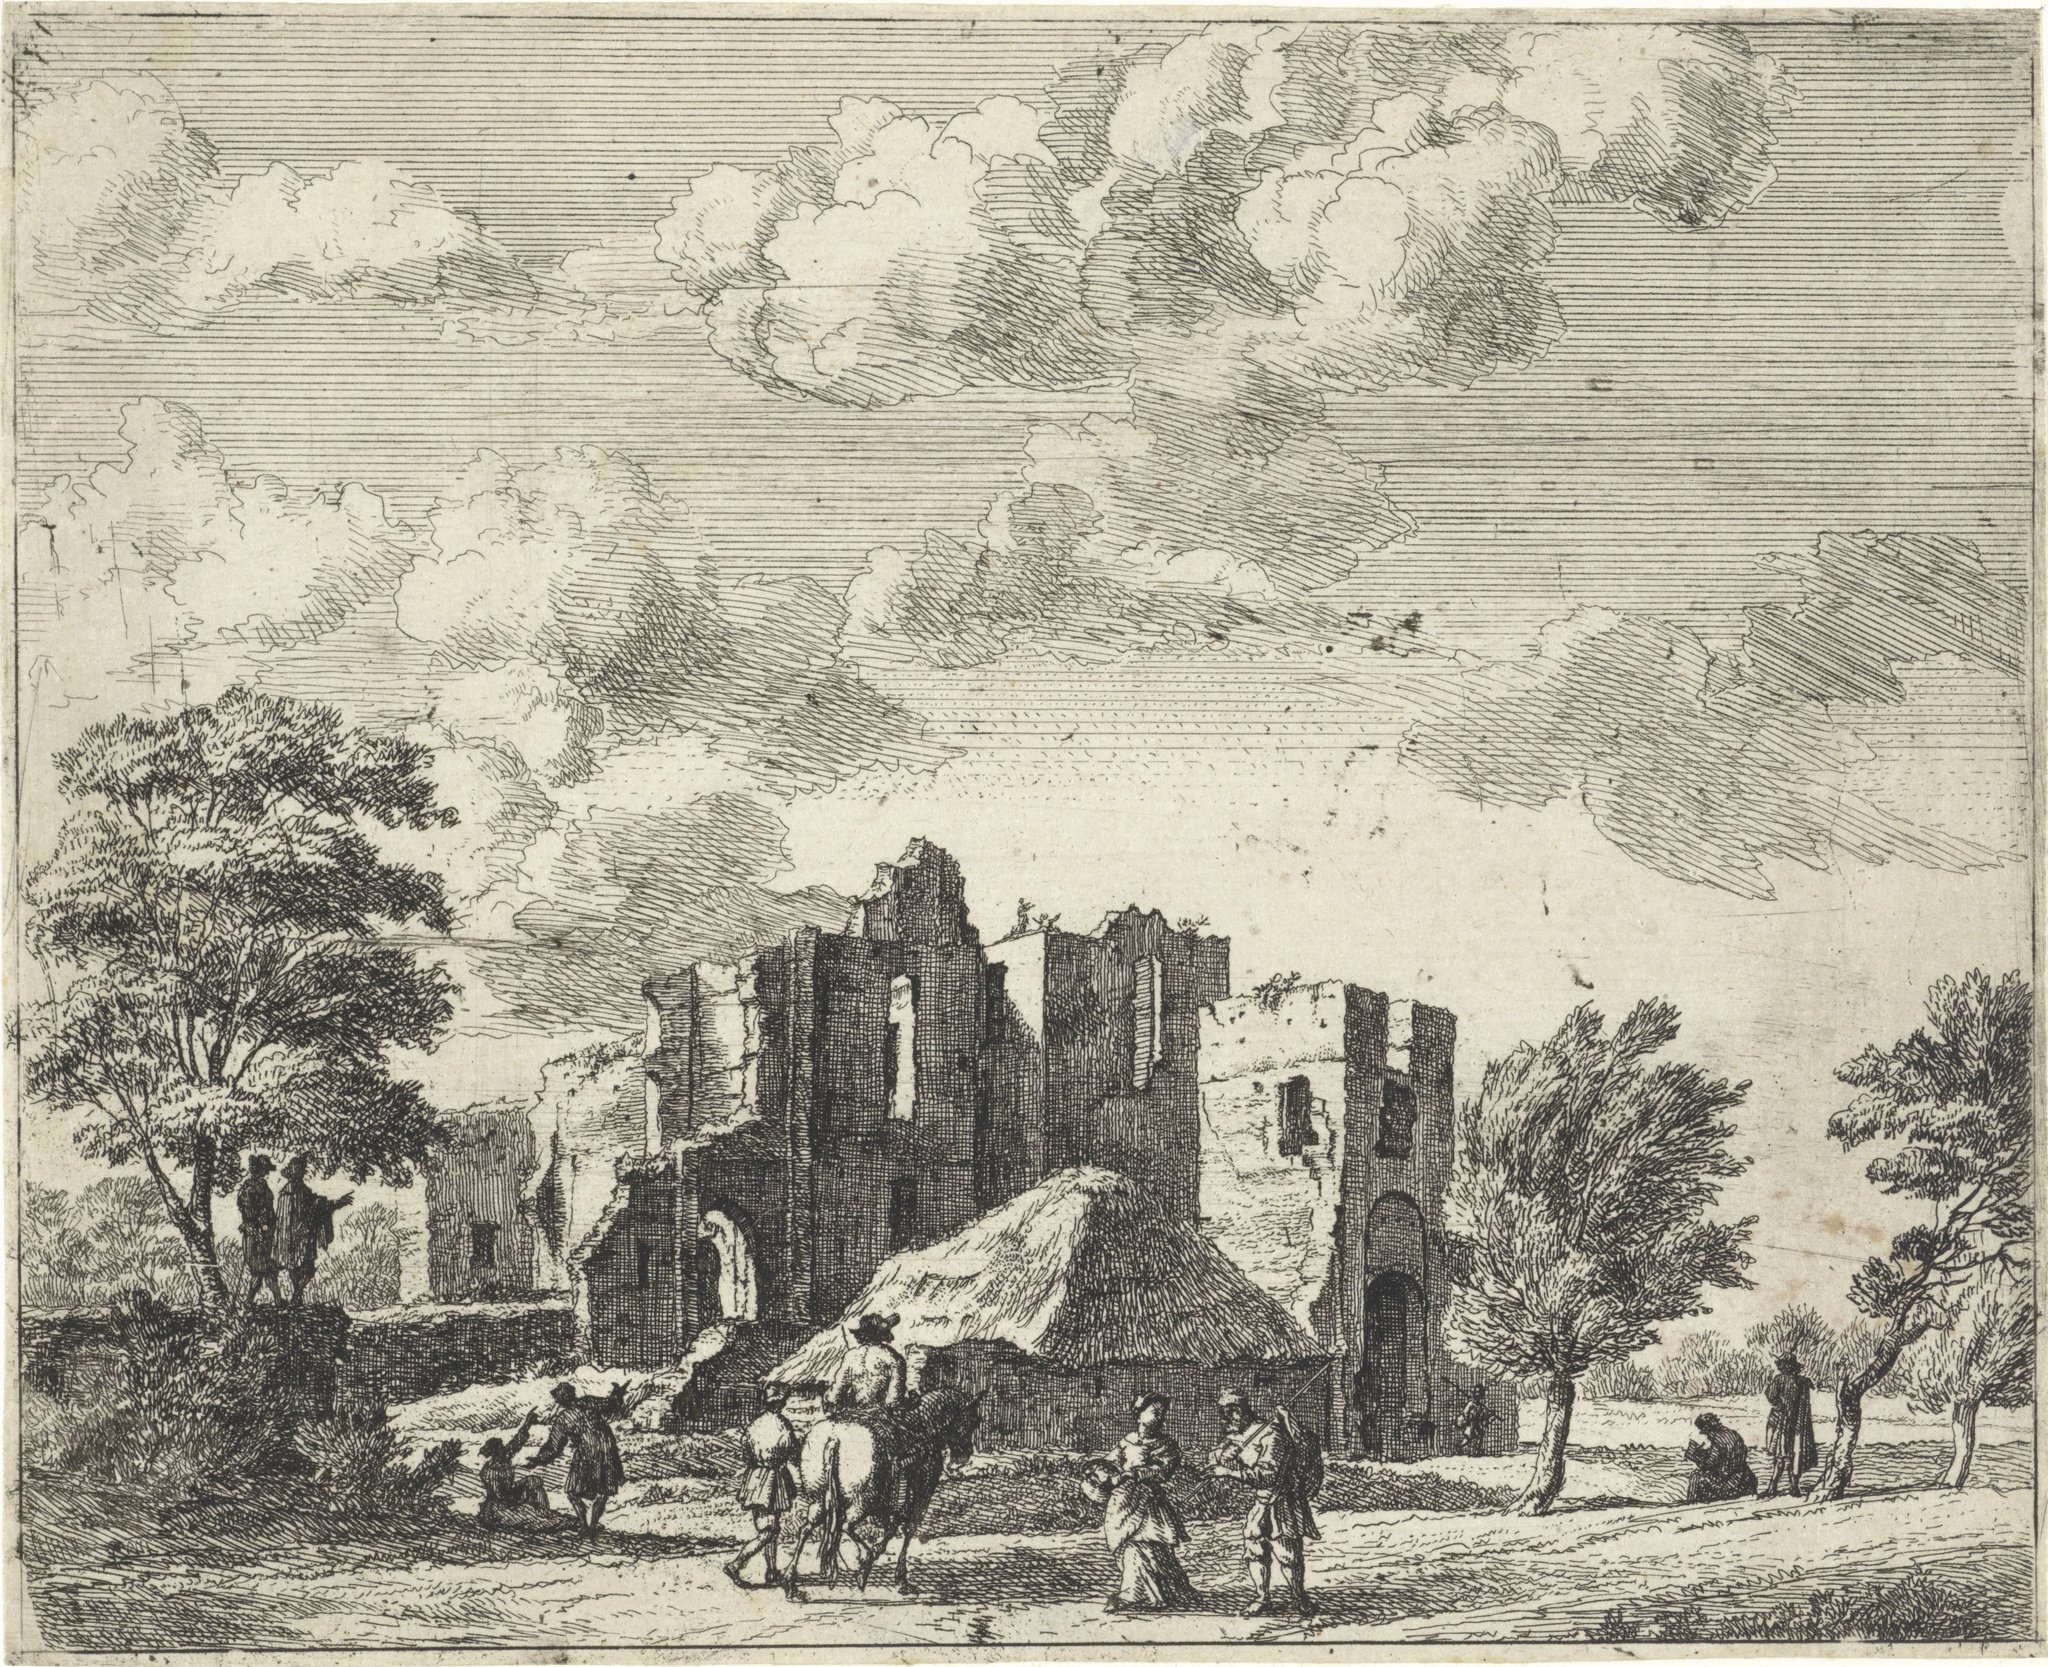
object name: print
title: Gezicht op de ruïne van Brederode, Haarlem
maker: jan vincentsz. van der vinne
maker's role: draughtsman, print maker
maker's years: 1663-1721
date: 1688-1721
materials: paper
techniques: etching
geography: haarlem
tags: riding a horse, ass, or mule; rider, horseman, landscape with ruins (+ city(-scape) with figures, staffage)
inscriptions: collector's mark: Lugt 240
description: Verschillende figuren en een ruiter bij de ruïne van Kasteel Brederode te Haarlem.